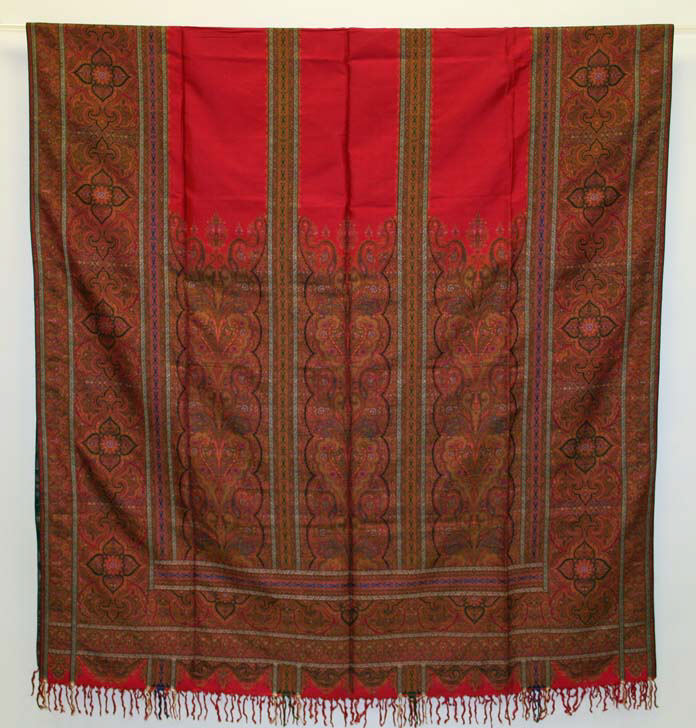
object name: shawl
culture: british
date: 1860-1865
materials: silk